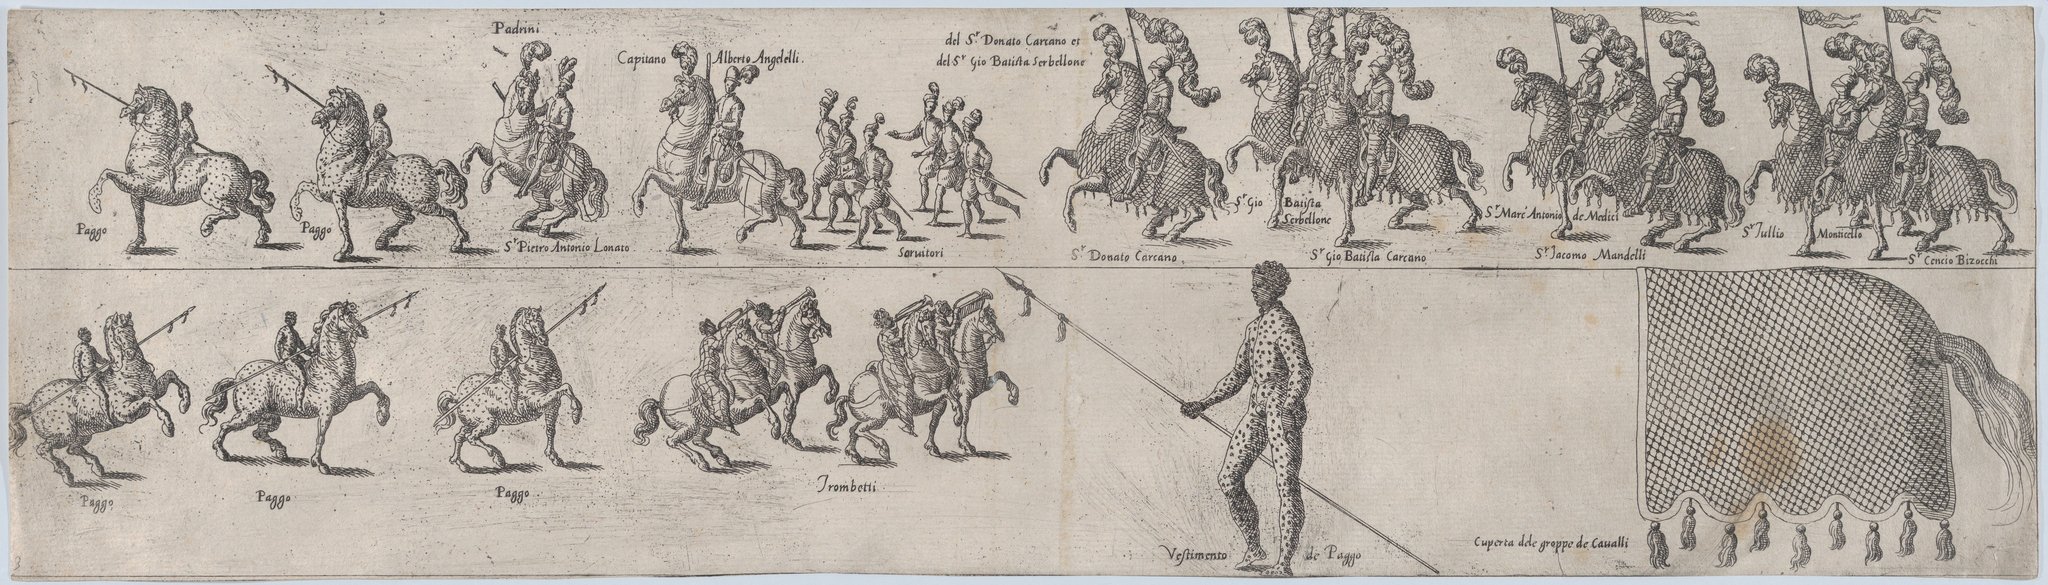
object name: print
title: Plate depicting Donato Carcano, from a series of twelve showing knights and their attendants dressed for a tournament (plate 3)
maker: Anonymous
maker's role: artist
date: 1565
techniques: etching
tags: spears,men,horses,knights